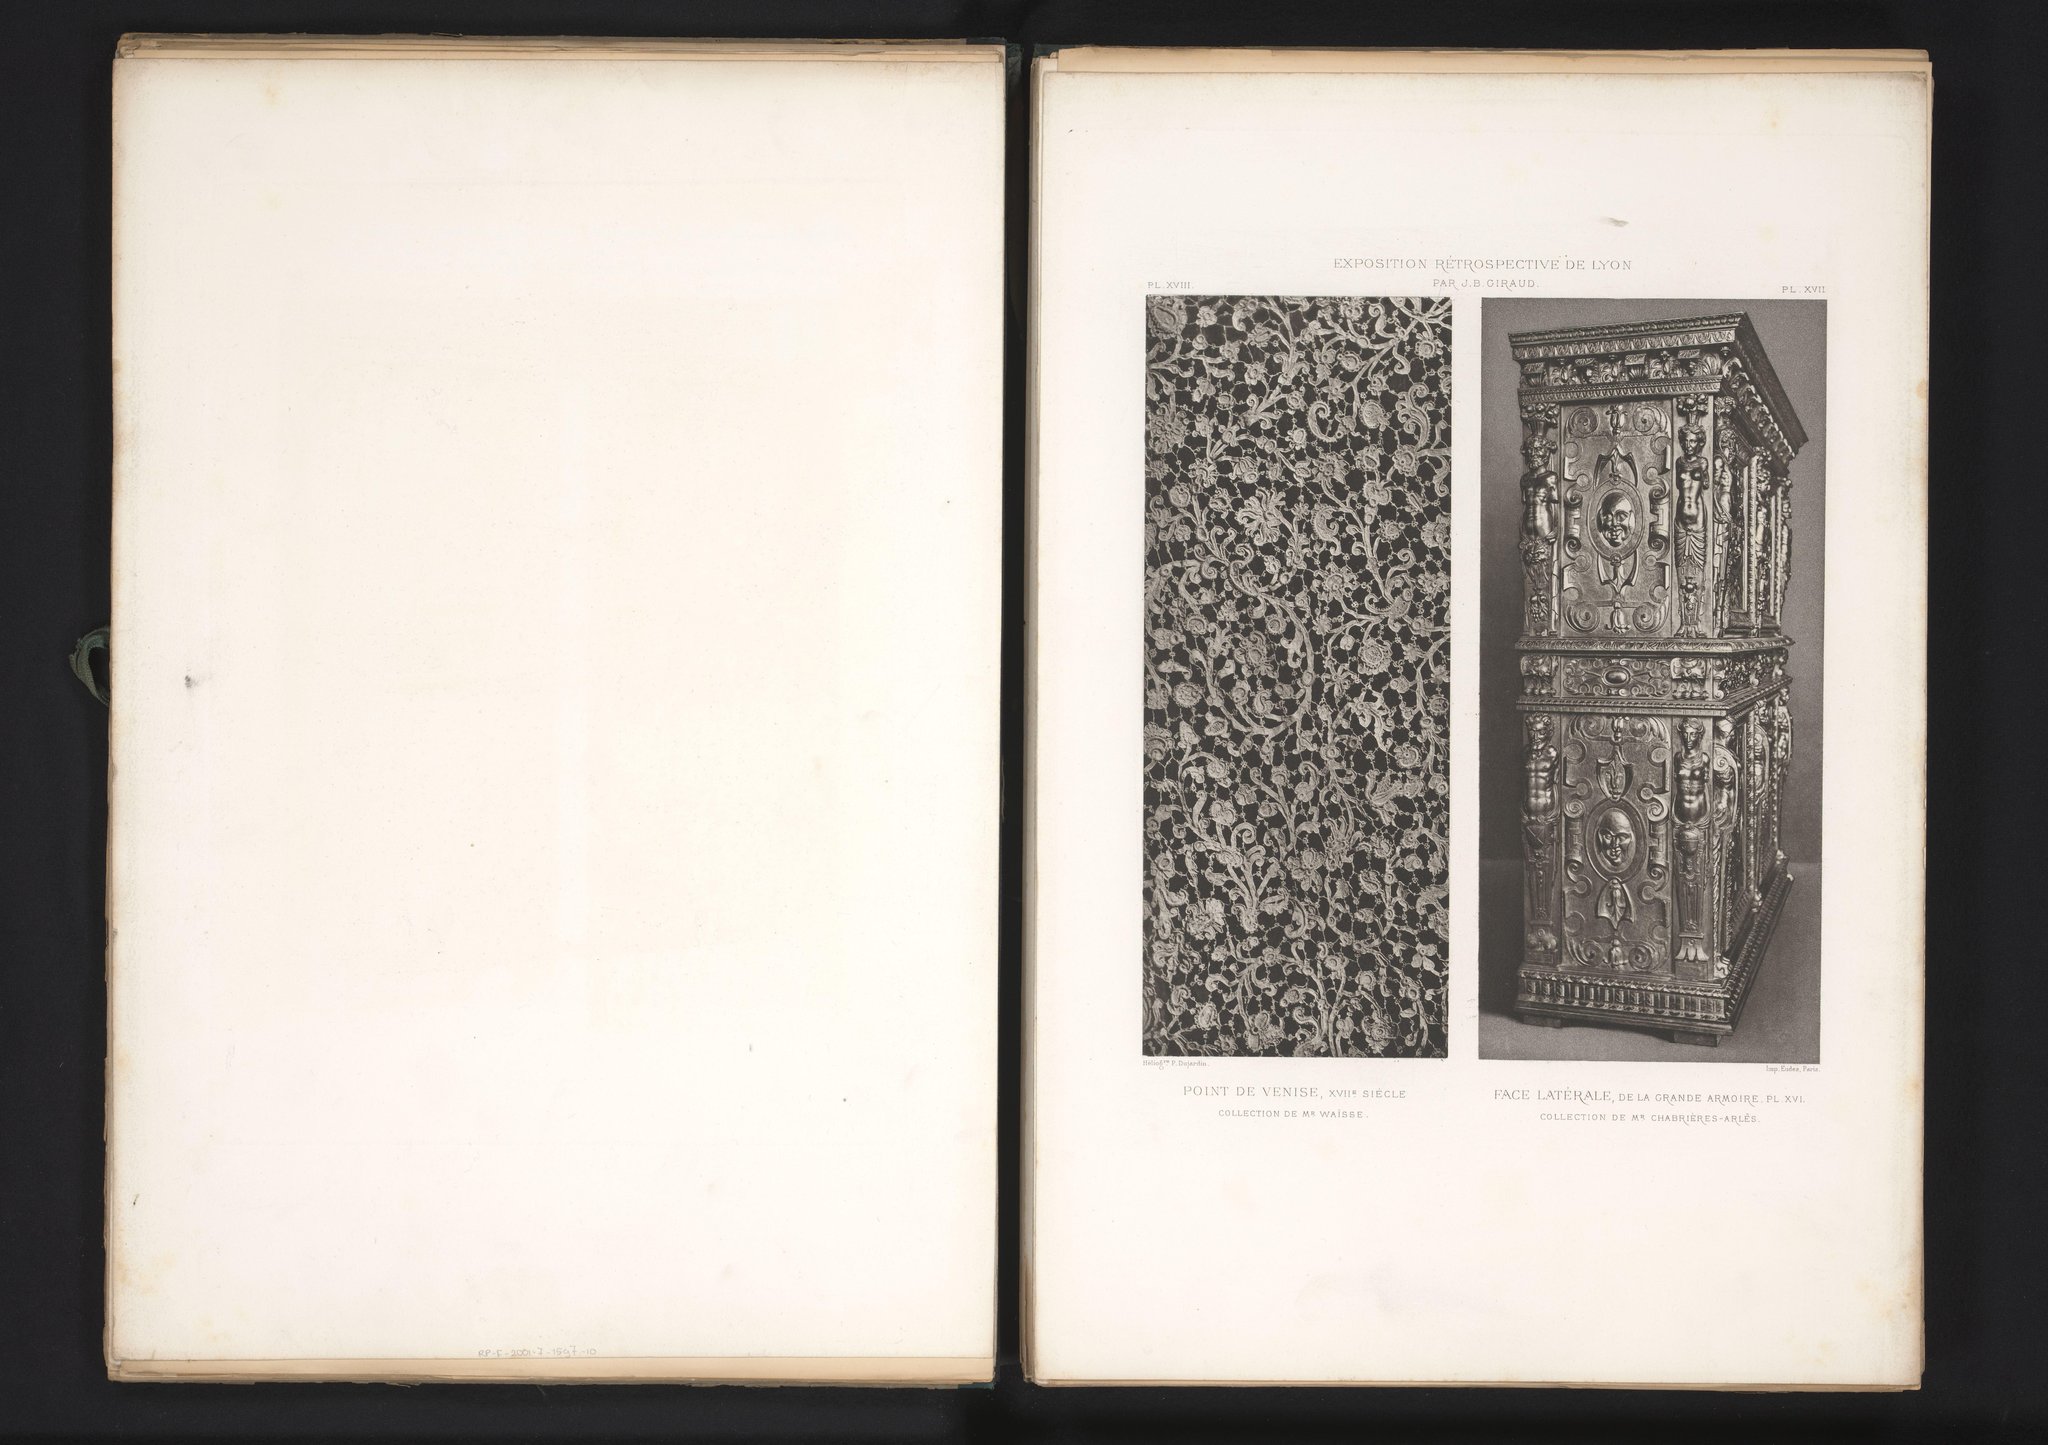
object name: photomechanical print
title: Stuk Venetiaans kant en een zijaanzicht van een 16de-eeuwse kast van hout, op de Exposition Rétrospective van 1877 in Lyon, Frankrijk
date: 1877-1878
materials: paper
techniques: photoaquatint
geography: lyon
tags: ornamental cupboard (+ wood and other phytogenic material), lace, lyon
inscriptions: inscription: ‘EXPOSITION RÉTROSPECTIVE DE LYON/ PAR J. B. GIRAUD.’, number: ‘PL. XVII.’, inscription: ‘POINT DE VENISE, XVIIe SIÈCLE/ COLLECTION DE Mr WAÏSSE.’, number: ‘PL. XVIII.’, inscription: ‘FACE LATÉRALE, DE LA GRANDE ARMOIRE PL. XVI./ COLLECTION DE Mr CHABRIÈRES-ARLÈS.’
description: Deze prenten maken deel uit van een omslag met 79 prenten op 54 bladen en 65 tekstbladen.